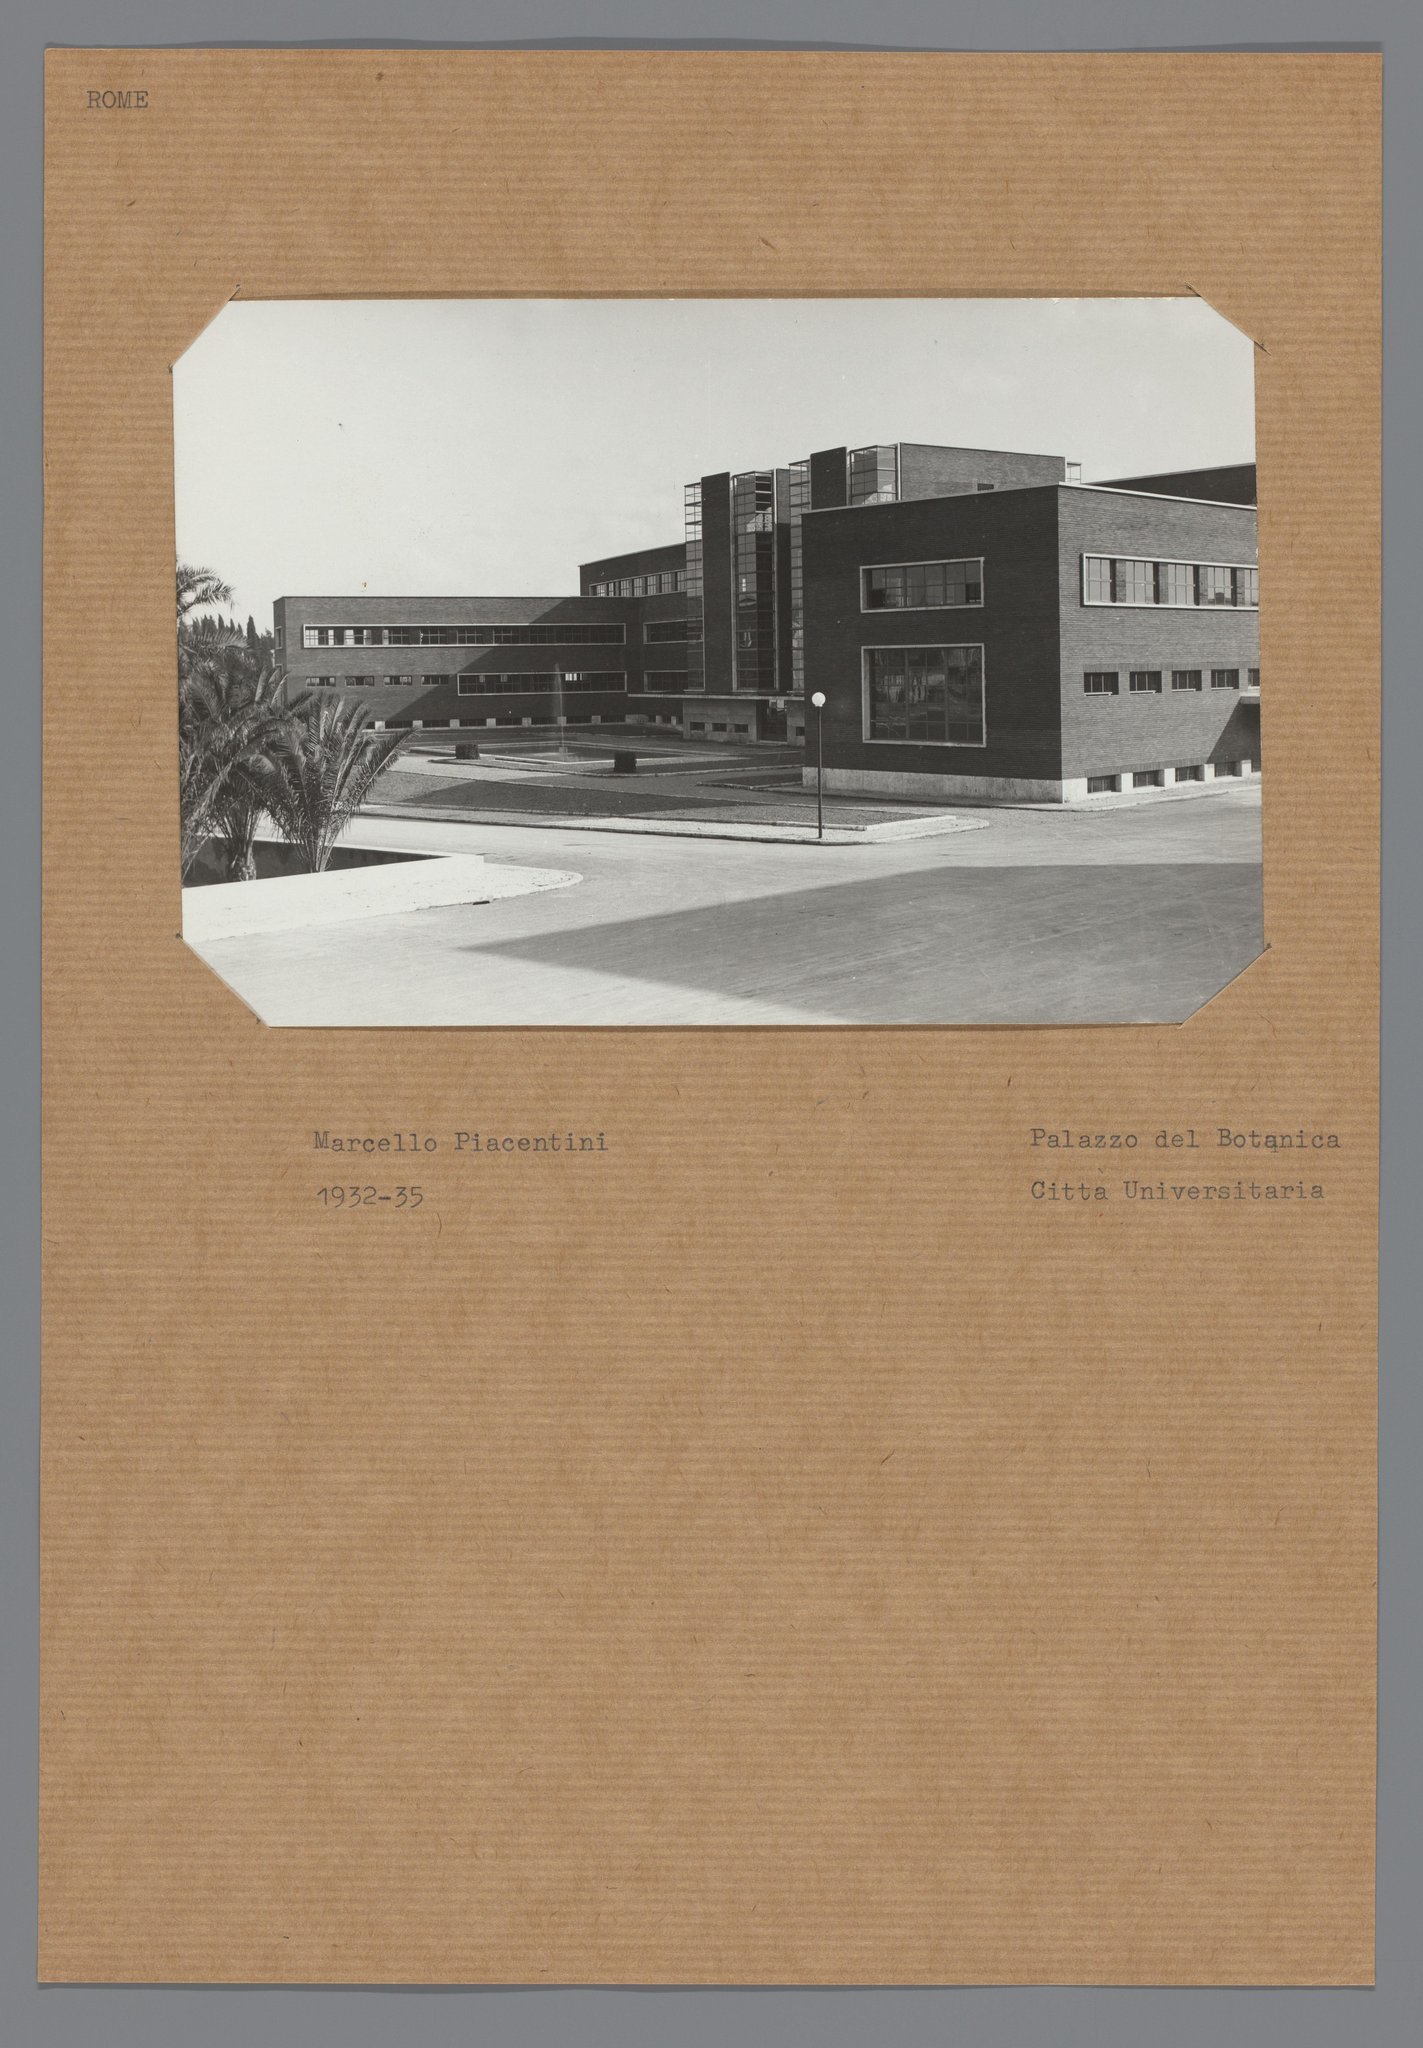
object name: photograph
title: Italië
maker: Anonymous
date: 1880-1910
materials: photographic support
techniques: albumen print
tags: italy